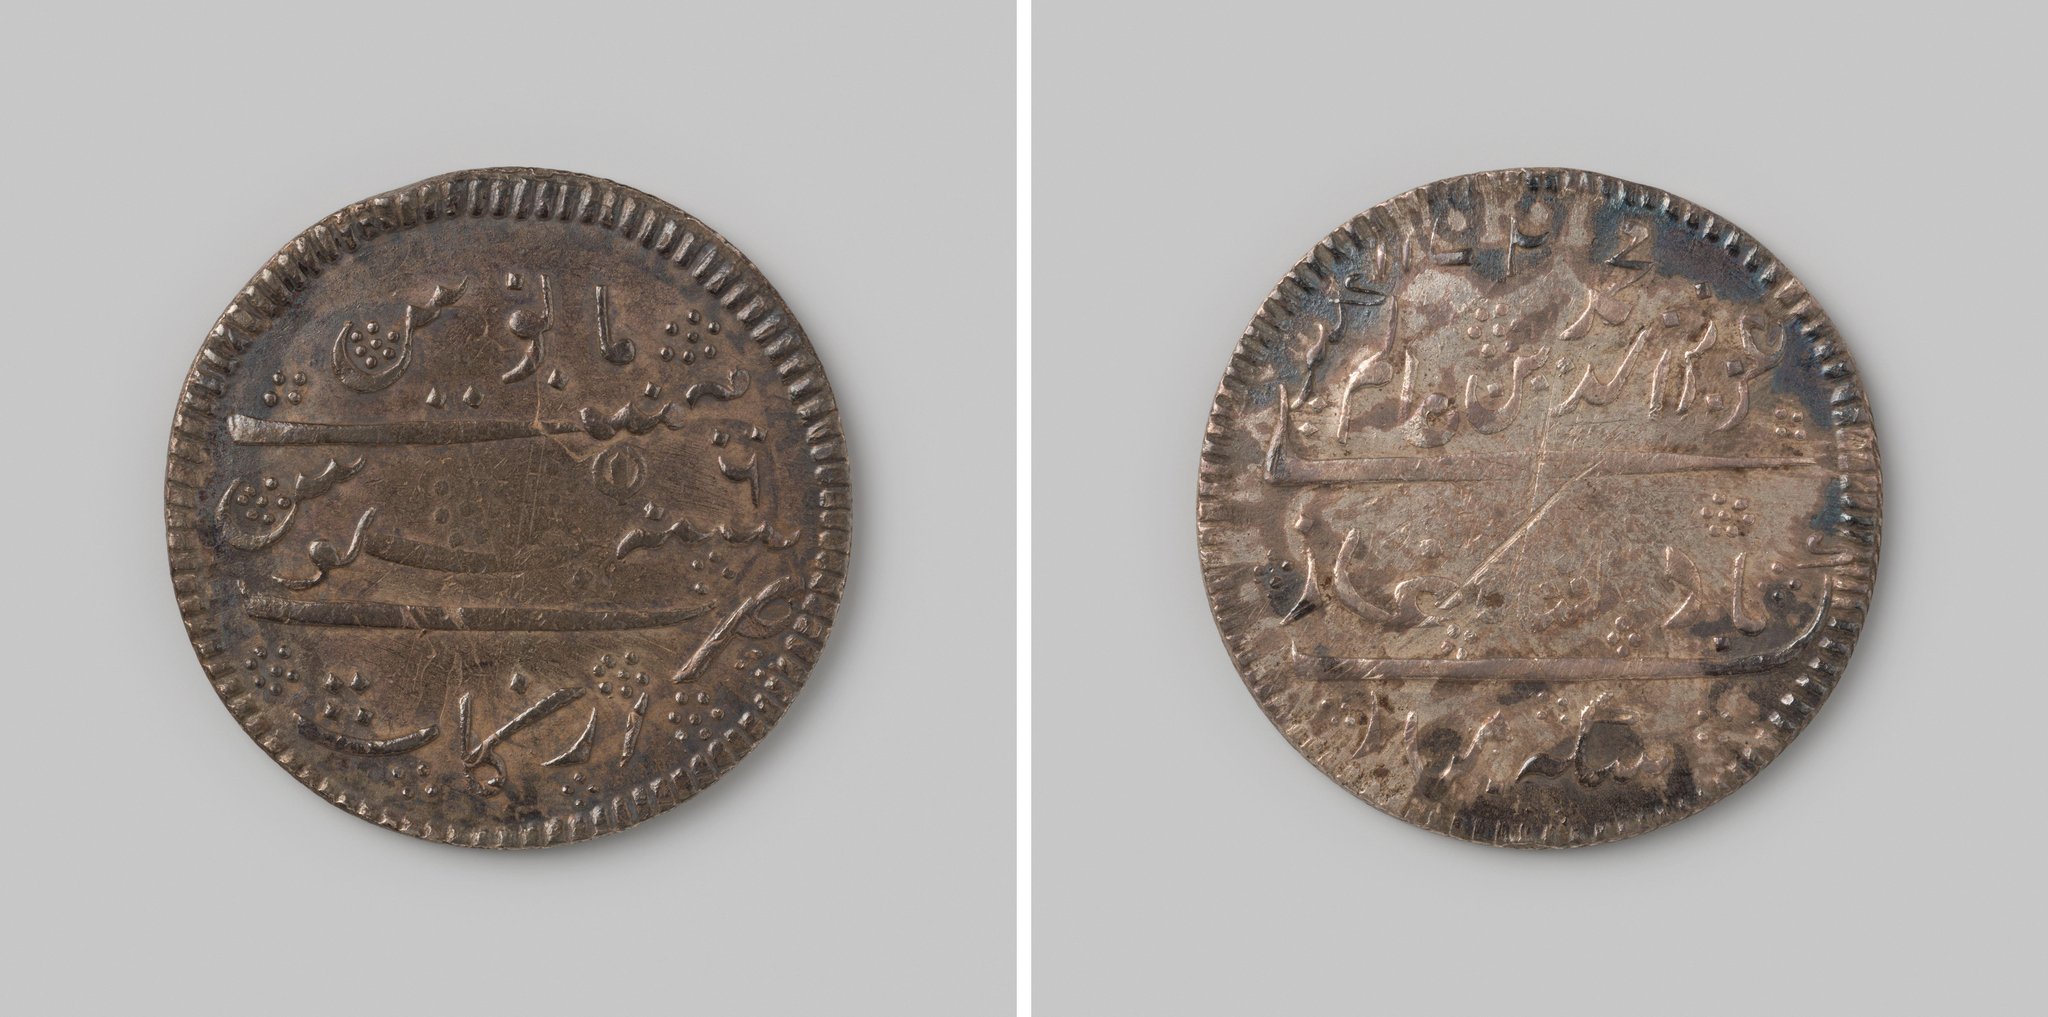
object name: coin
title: Dubbele arcot-roepie voor Madras in India van de Engelse Oostindische Compagnie (EIC), op naam van shah Alamgir II, (1807)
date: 1807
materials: silver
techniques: striking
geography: chennai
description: Zilveren munt. Voorzijde: opschrift in drie regels in Arabische lettertekens, waarin verwijzing naar shah Alamgir II. Links boven "bevroren" jaartal: 1172. Keerzijde: opschrift in drie regels in Arabische lettertekens. Rechts boven tweede regel lotusbloem. Kabelrand.